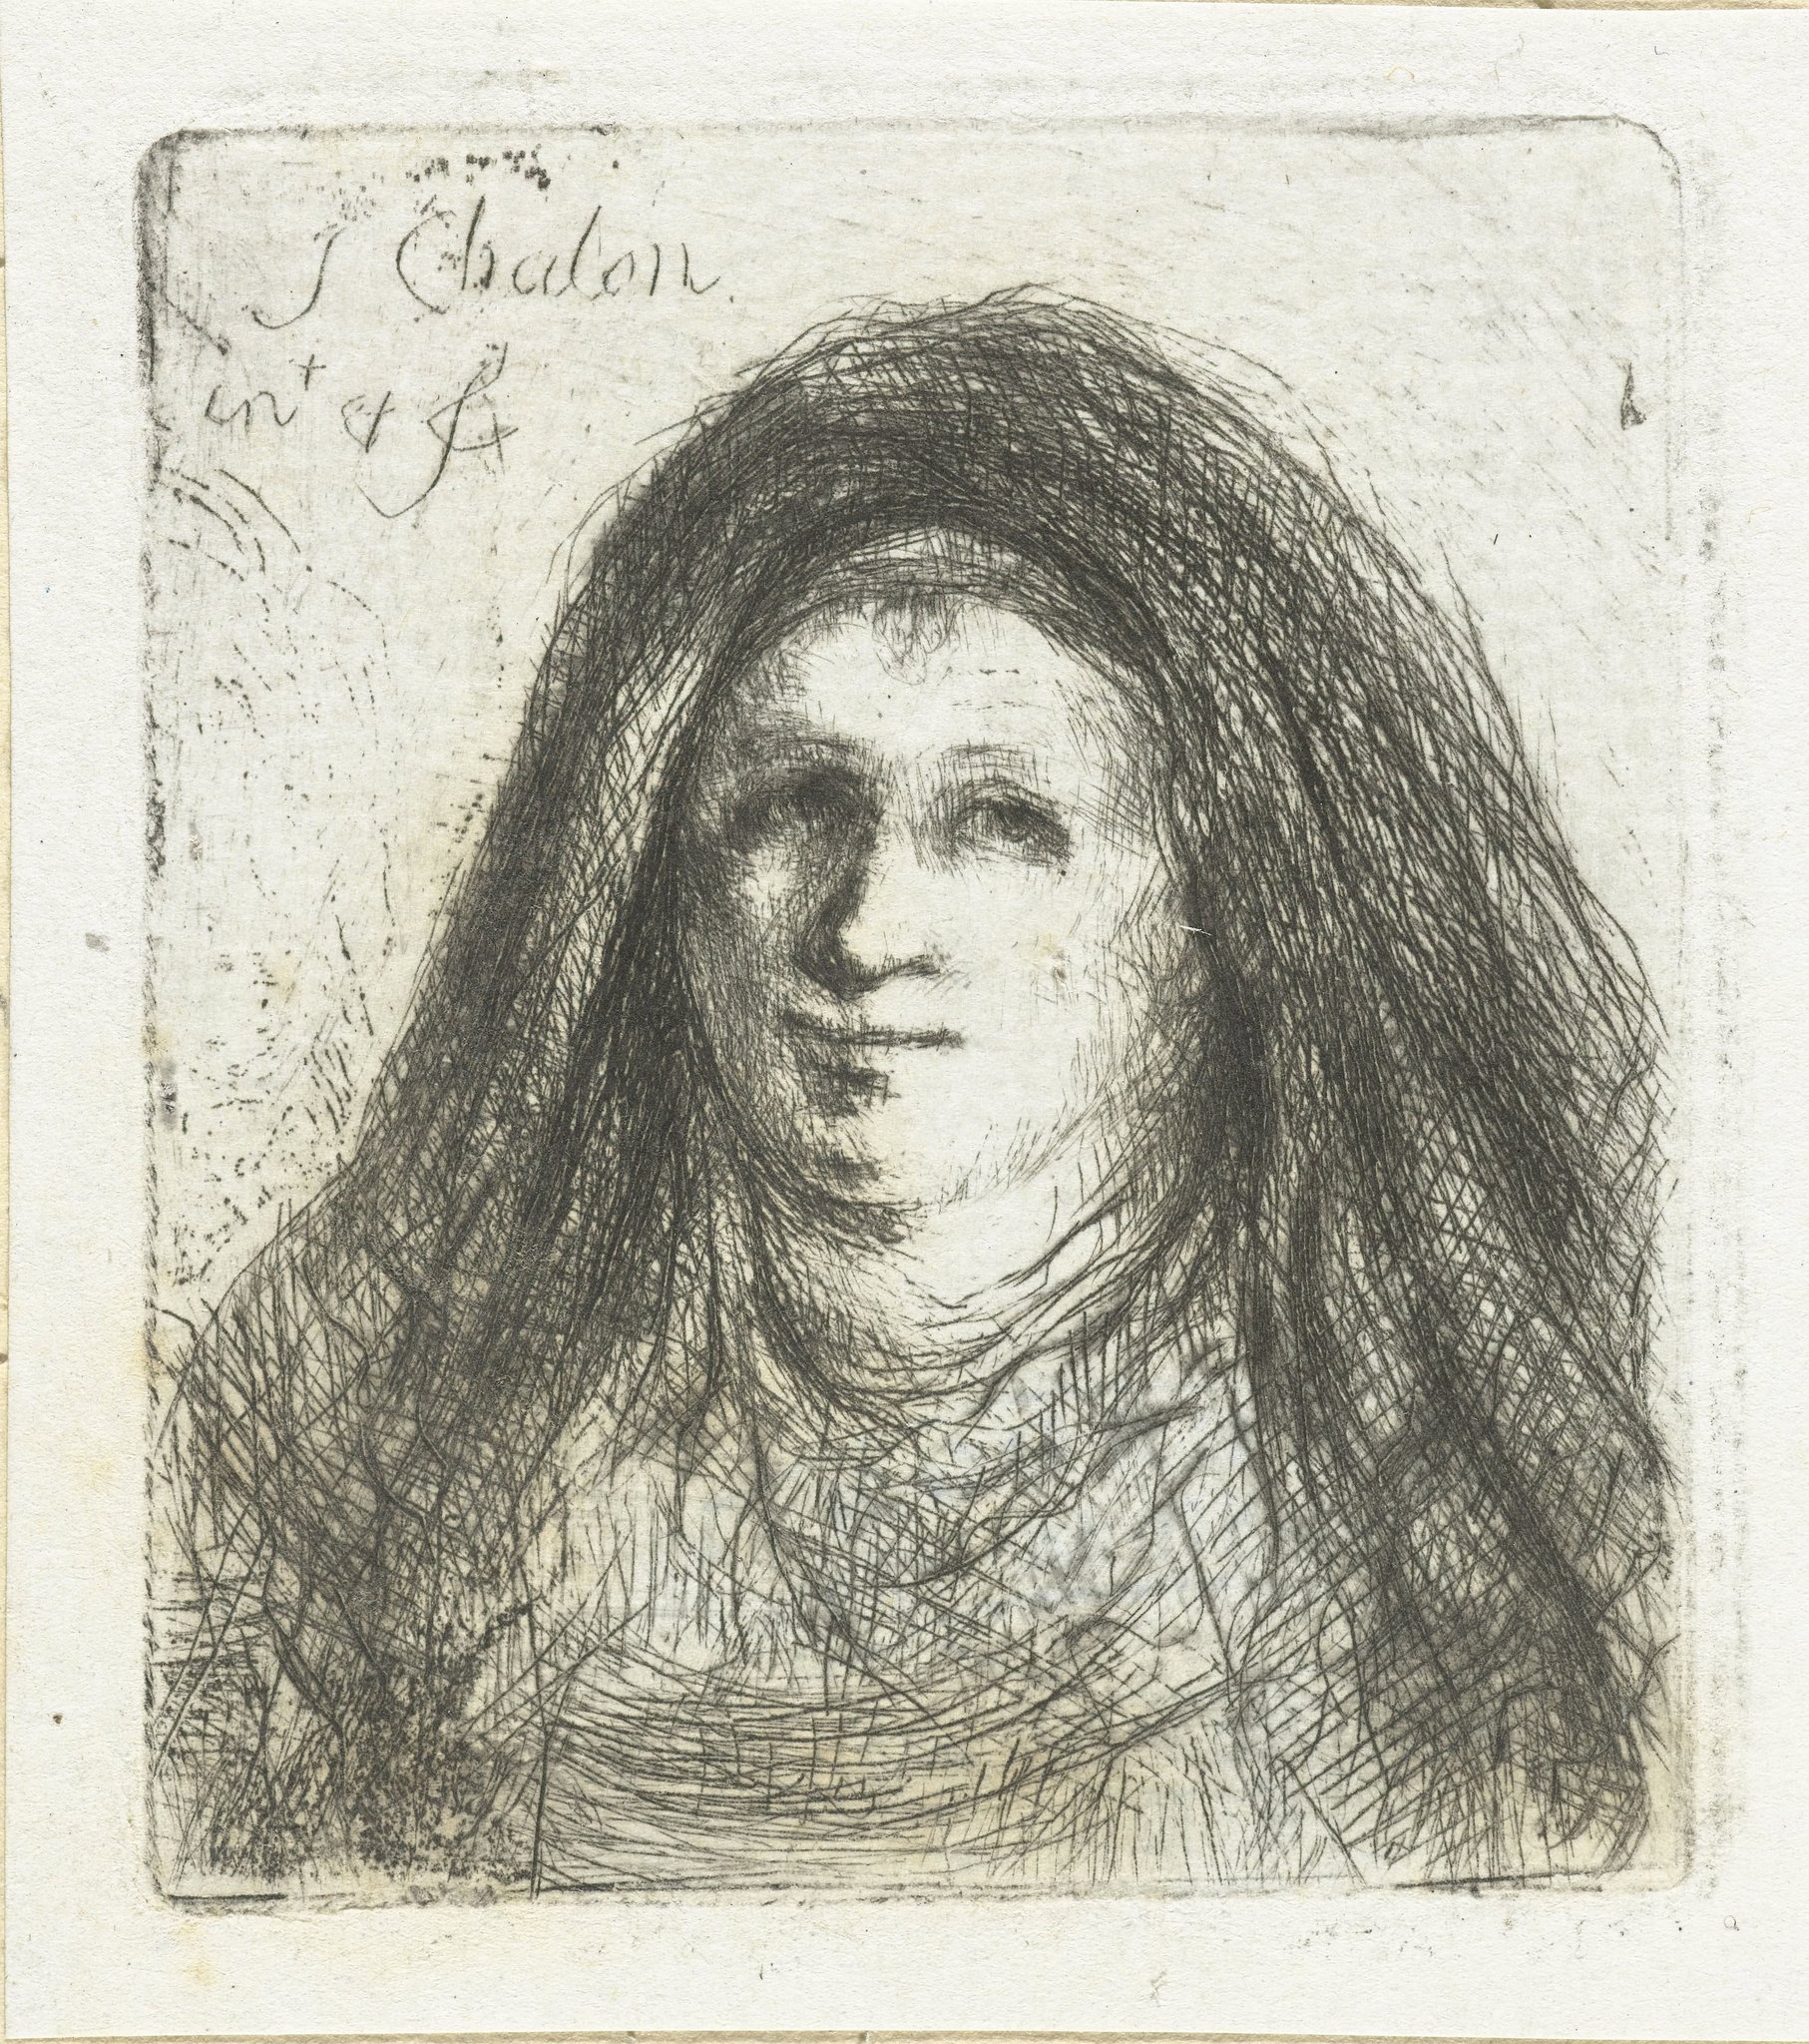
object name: print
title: Volwassen vrouw met hoofddoek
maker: jan chalon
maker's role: print maker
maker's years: 1738-1795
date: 1748-1795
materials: paper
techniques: drypoint, etching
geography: northern netherlands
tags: veil, morphology of human expression (+ adult female (human being))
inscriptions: collector's mark: Lugt 924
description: Een volwassen vrouw met hoofddoek. Buste naar links.